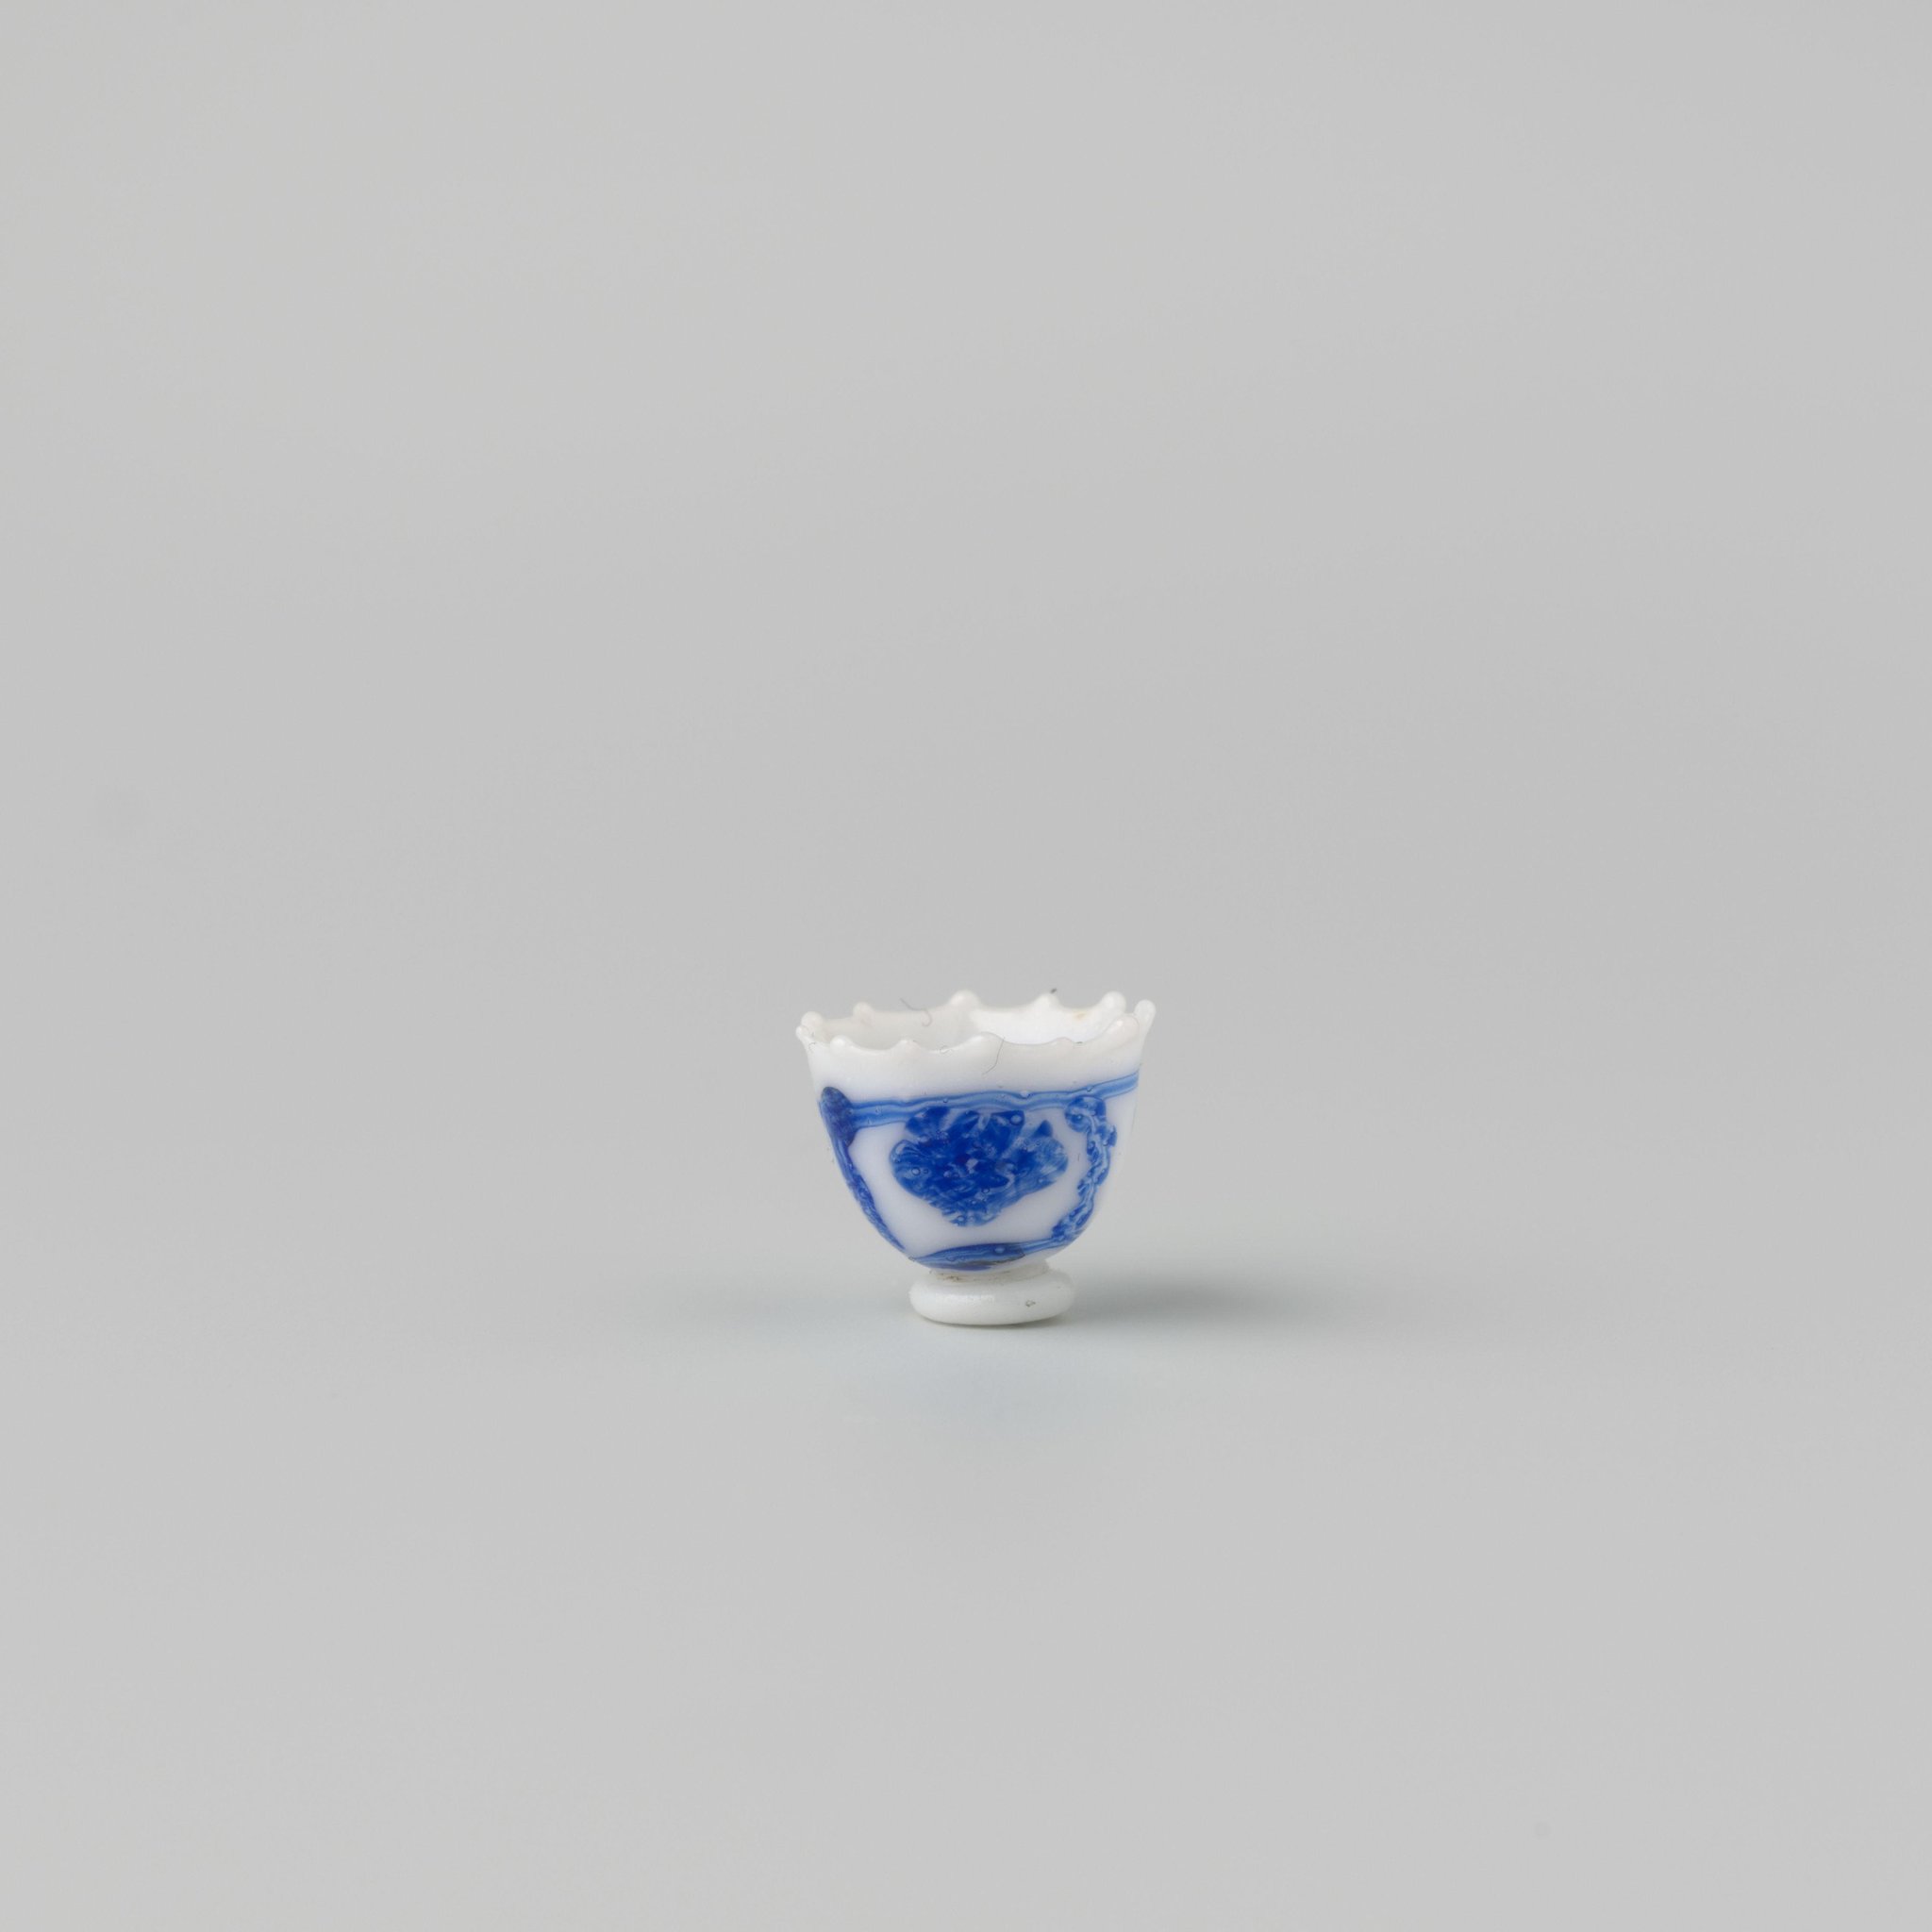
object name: cup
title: Theekopje van melkglas met blauwe emailverf beschildering, imitatie Chinees porselein met 'bloem' decoratie in vakken; model op los aangebrachte standring en met puntrand.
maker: Anonymous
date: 1675-1710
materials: glass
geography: amsterdam